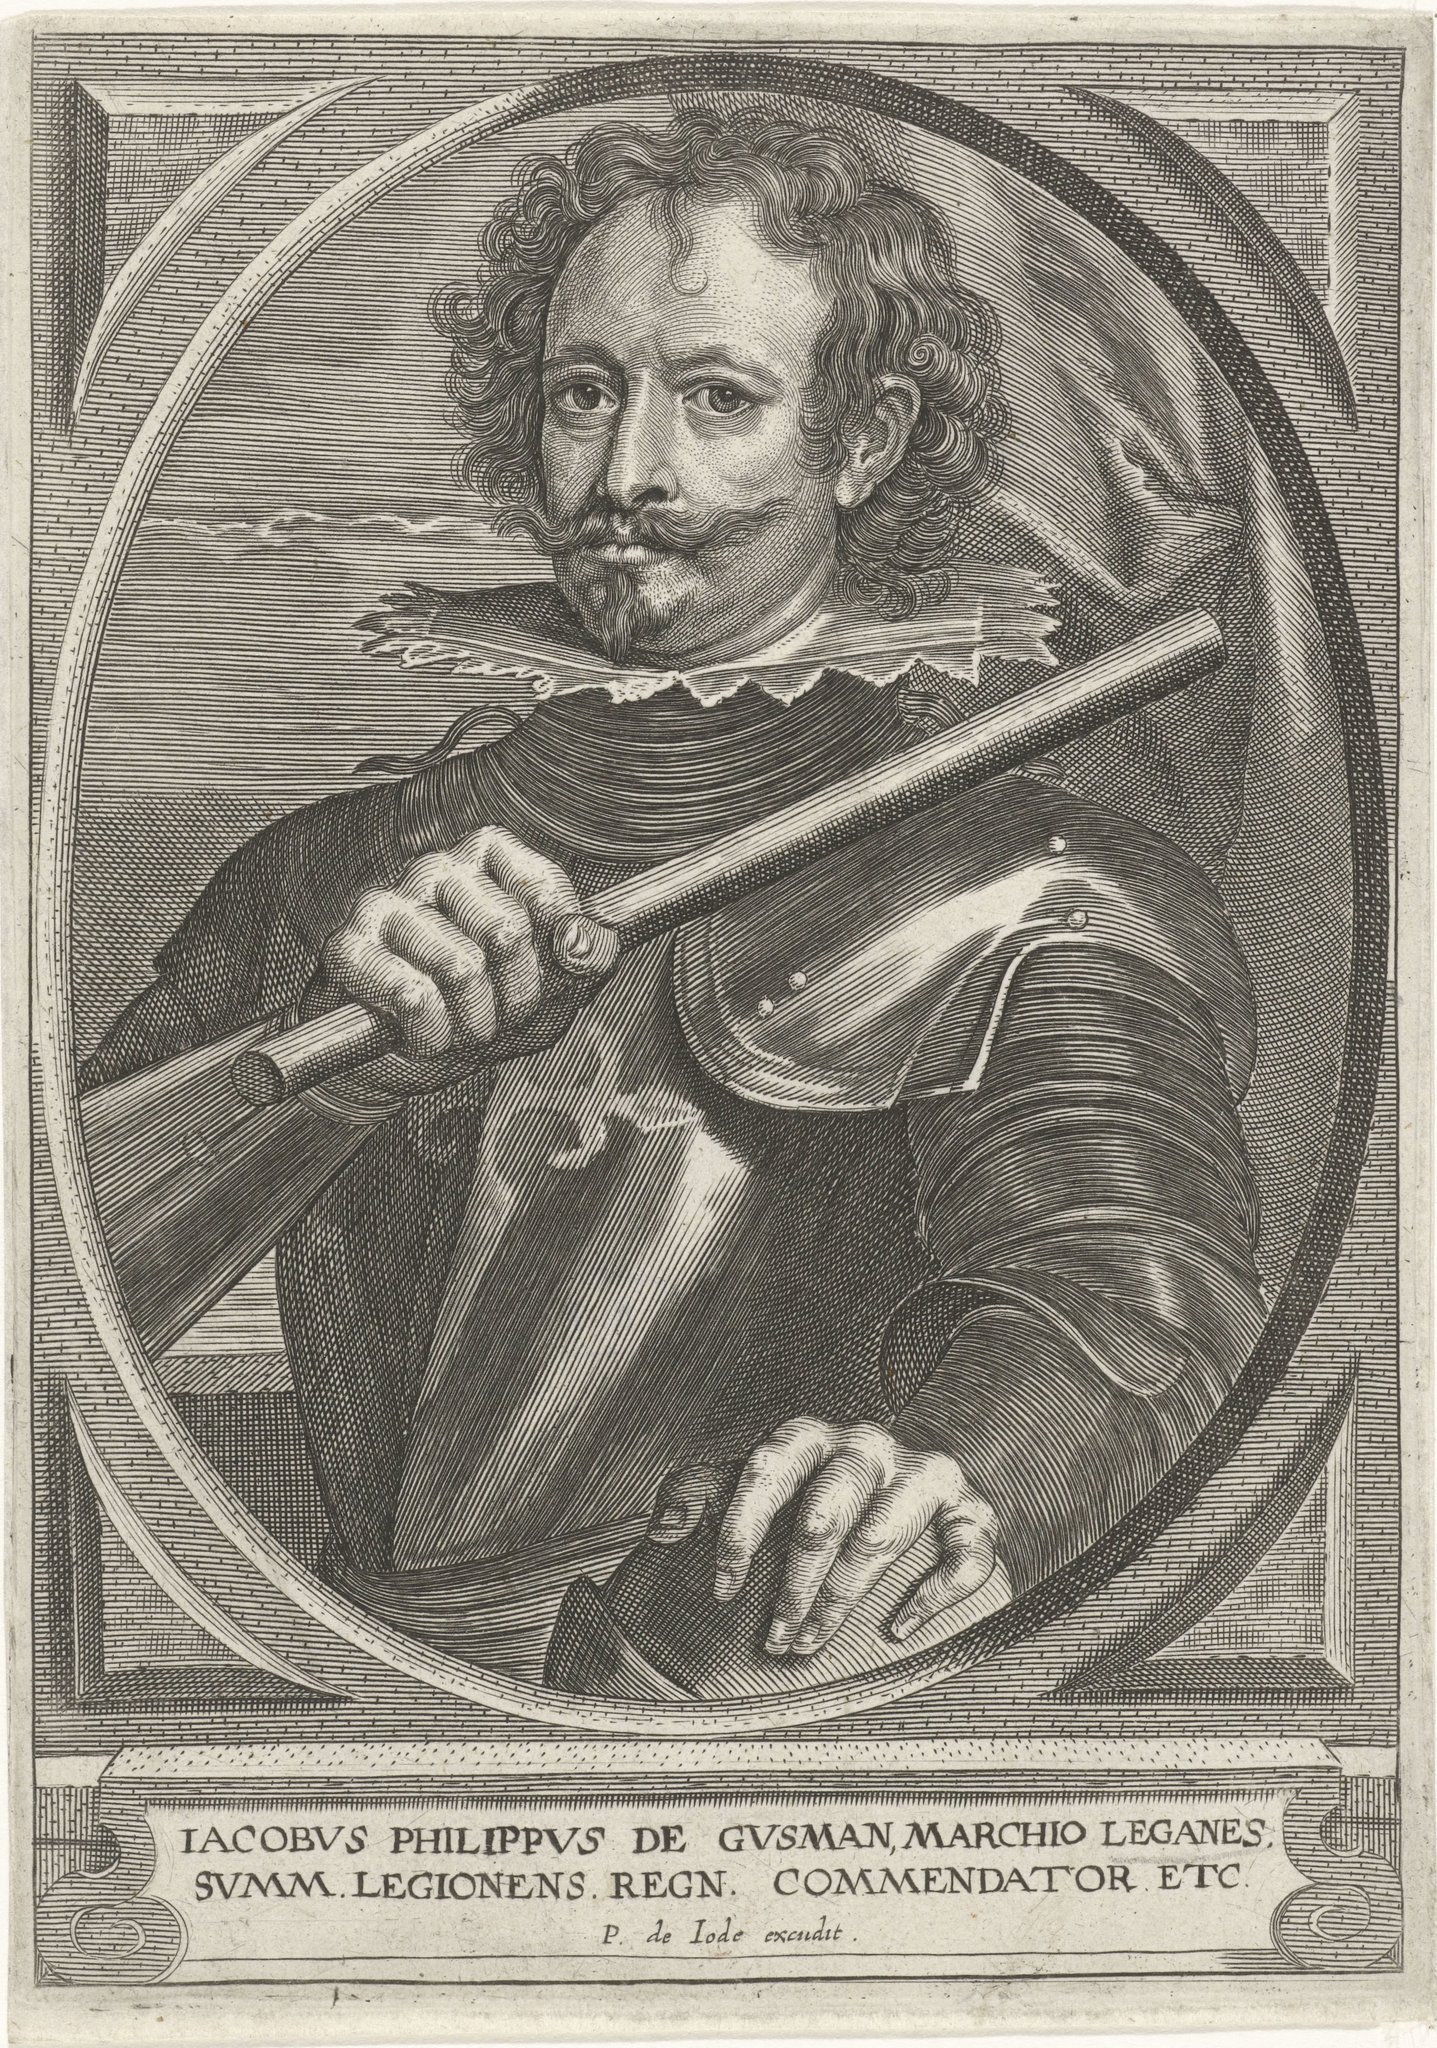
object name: print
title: Theater van bisschoppen, keizers, koningen, hertogen, prinsen, enz.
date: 1628-1670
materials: paper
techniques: engraving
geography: antwerp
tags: diego felipez de guzmán (markies van leganés)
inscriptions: collector's mark: Lugt 2228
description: Portret van Diego Felipez de Guzmán, markies van Leganés, ten halven lijve. Hij draagt een harnas en in zijn rechterhand houdt hij een commandostaf, zijn linkerhand rust op zijn helm. Het portret is gevat in een ovale omlijsting met vierkant randwerk. In het kader een tweergelig onderschrift in het Latijn.